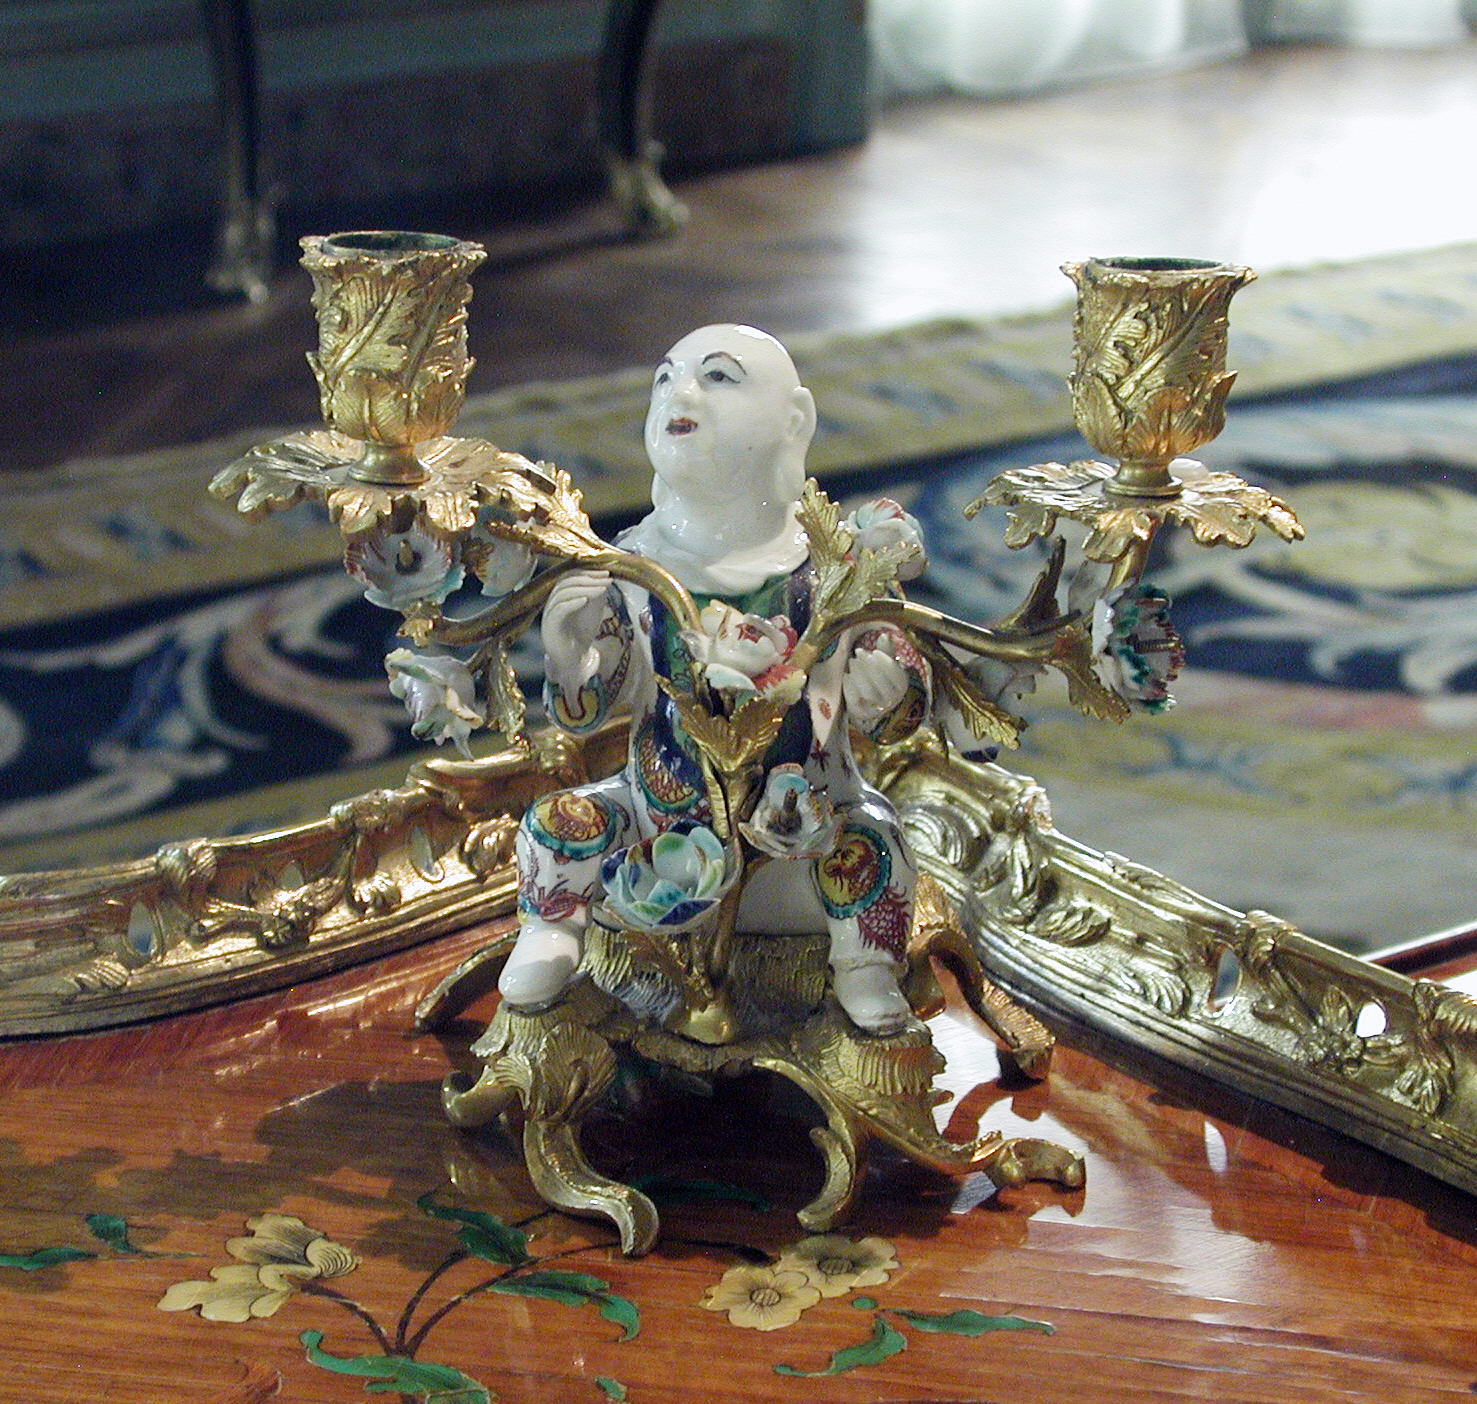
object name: candelabrum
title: Candelabrum (one of a pair)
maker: villeroy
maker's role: factory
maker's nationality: french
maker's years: 1734-1748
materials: gilt bronze, soft paste porcelain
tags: chinoiserie,boys